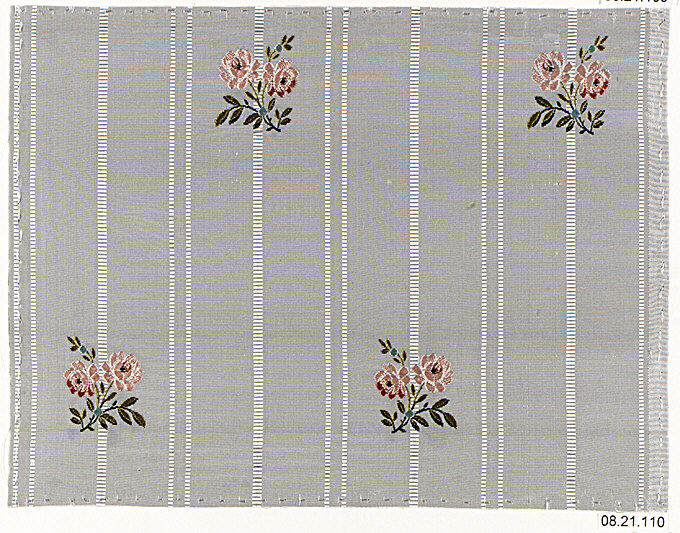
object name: textile sample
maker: Anonymous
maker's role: designer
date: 1900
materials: silk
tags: flowers